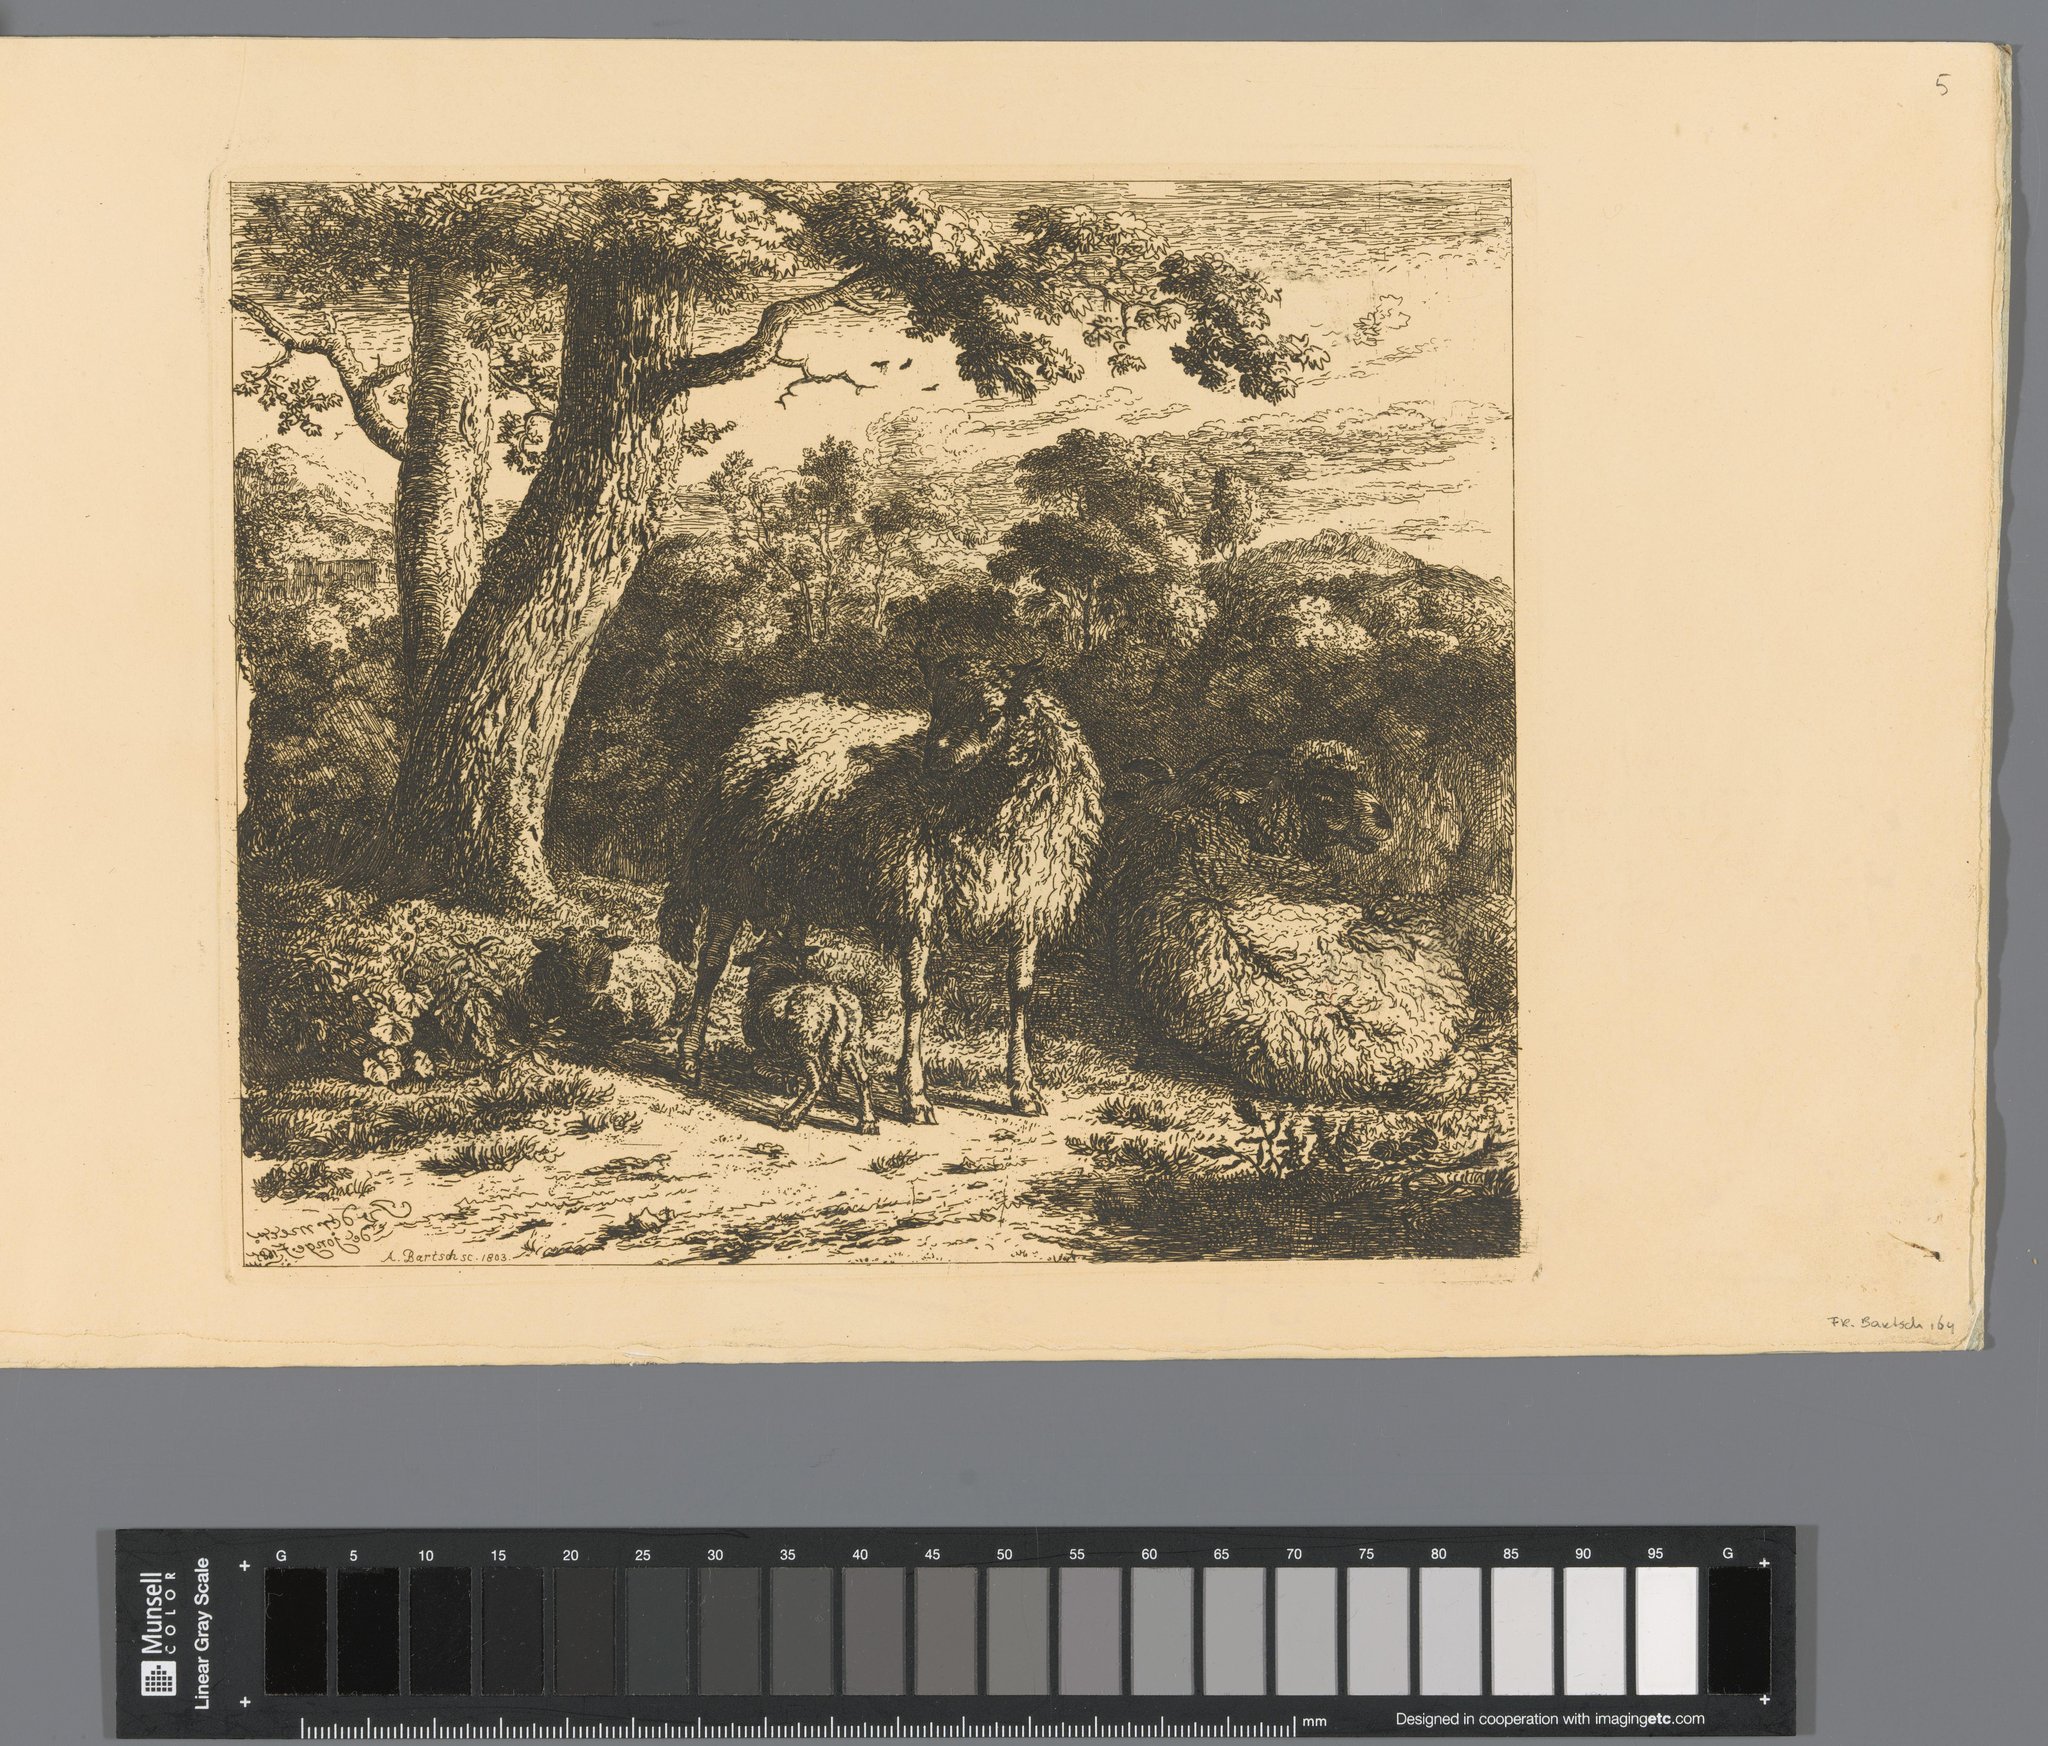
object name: print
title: Staand schaap met twee lammeren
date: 1803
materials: paper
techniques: etching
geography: haarlem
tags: sheep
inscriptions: collector's mark: Lugt 12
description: Deze prent maakt deel uit van een album.